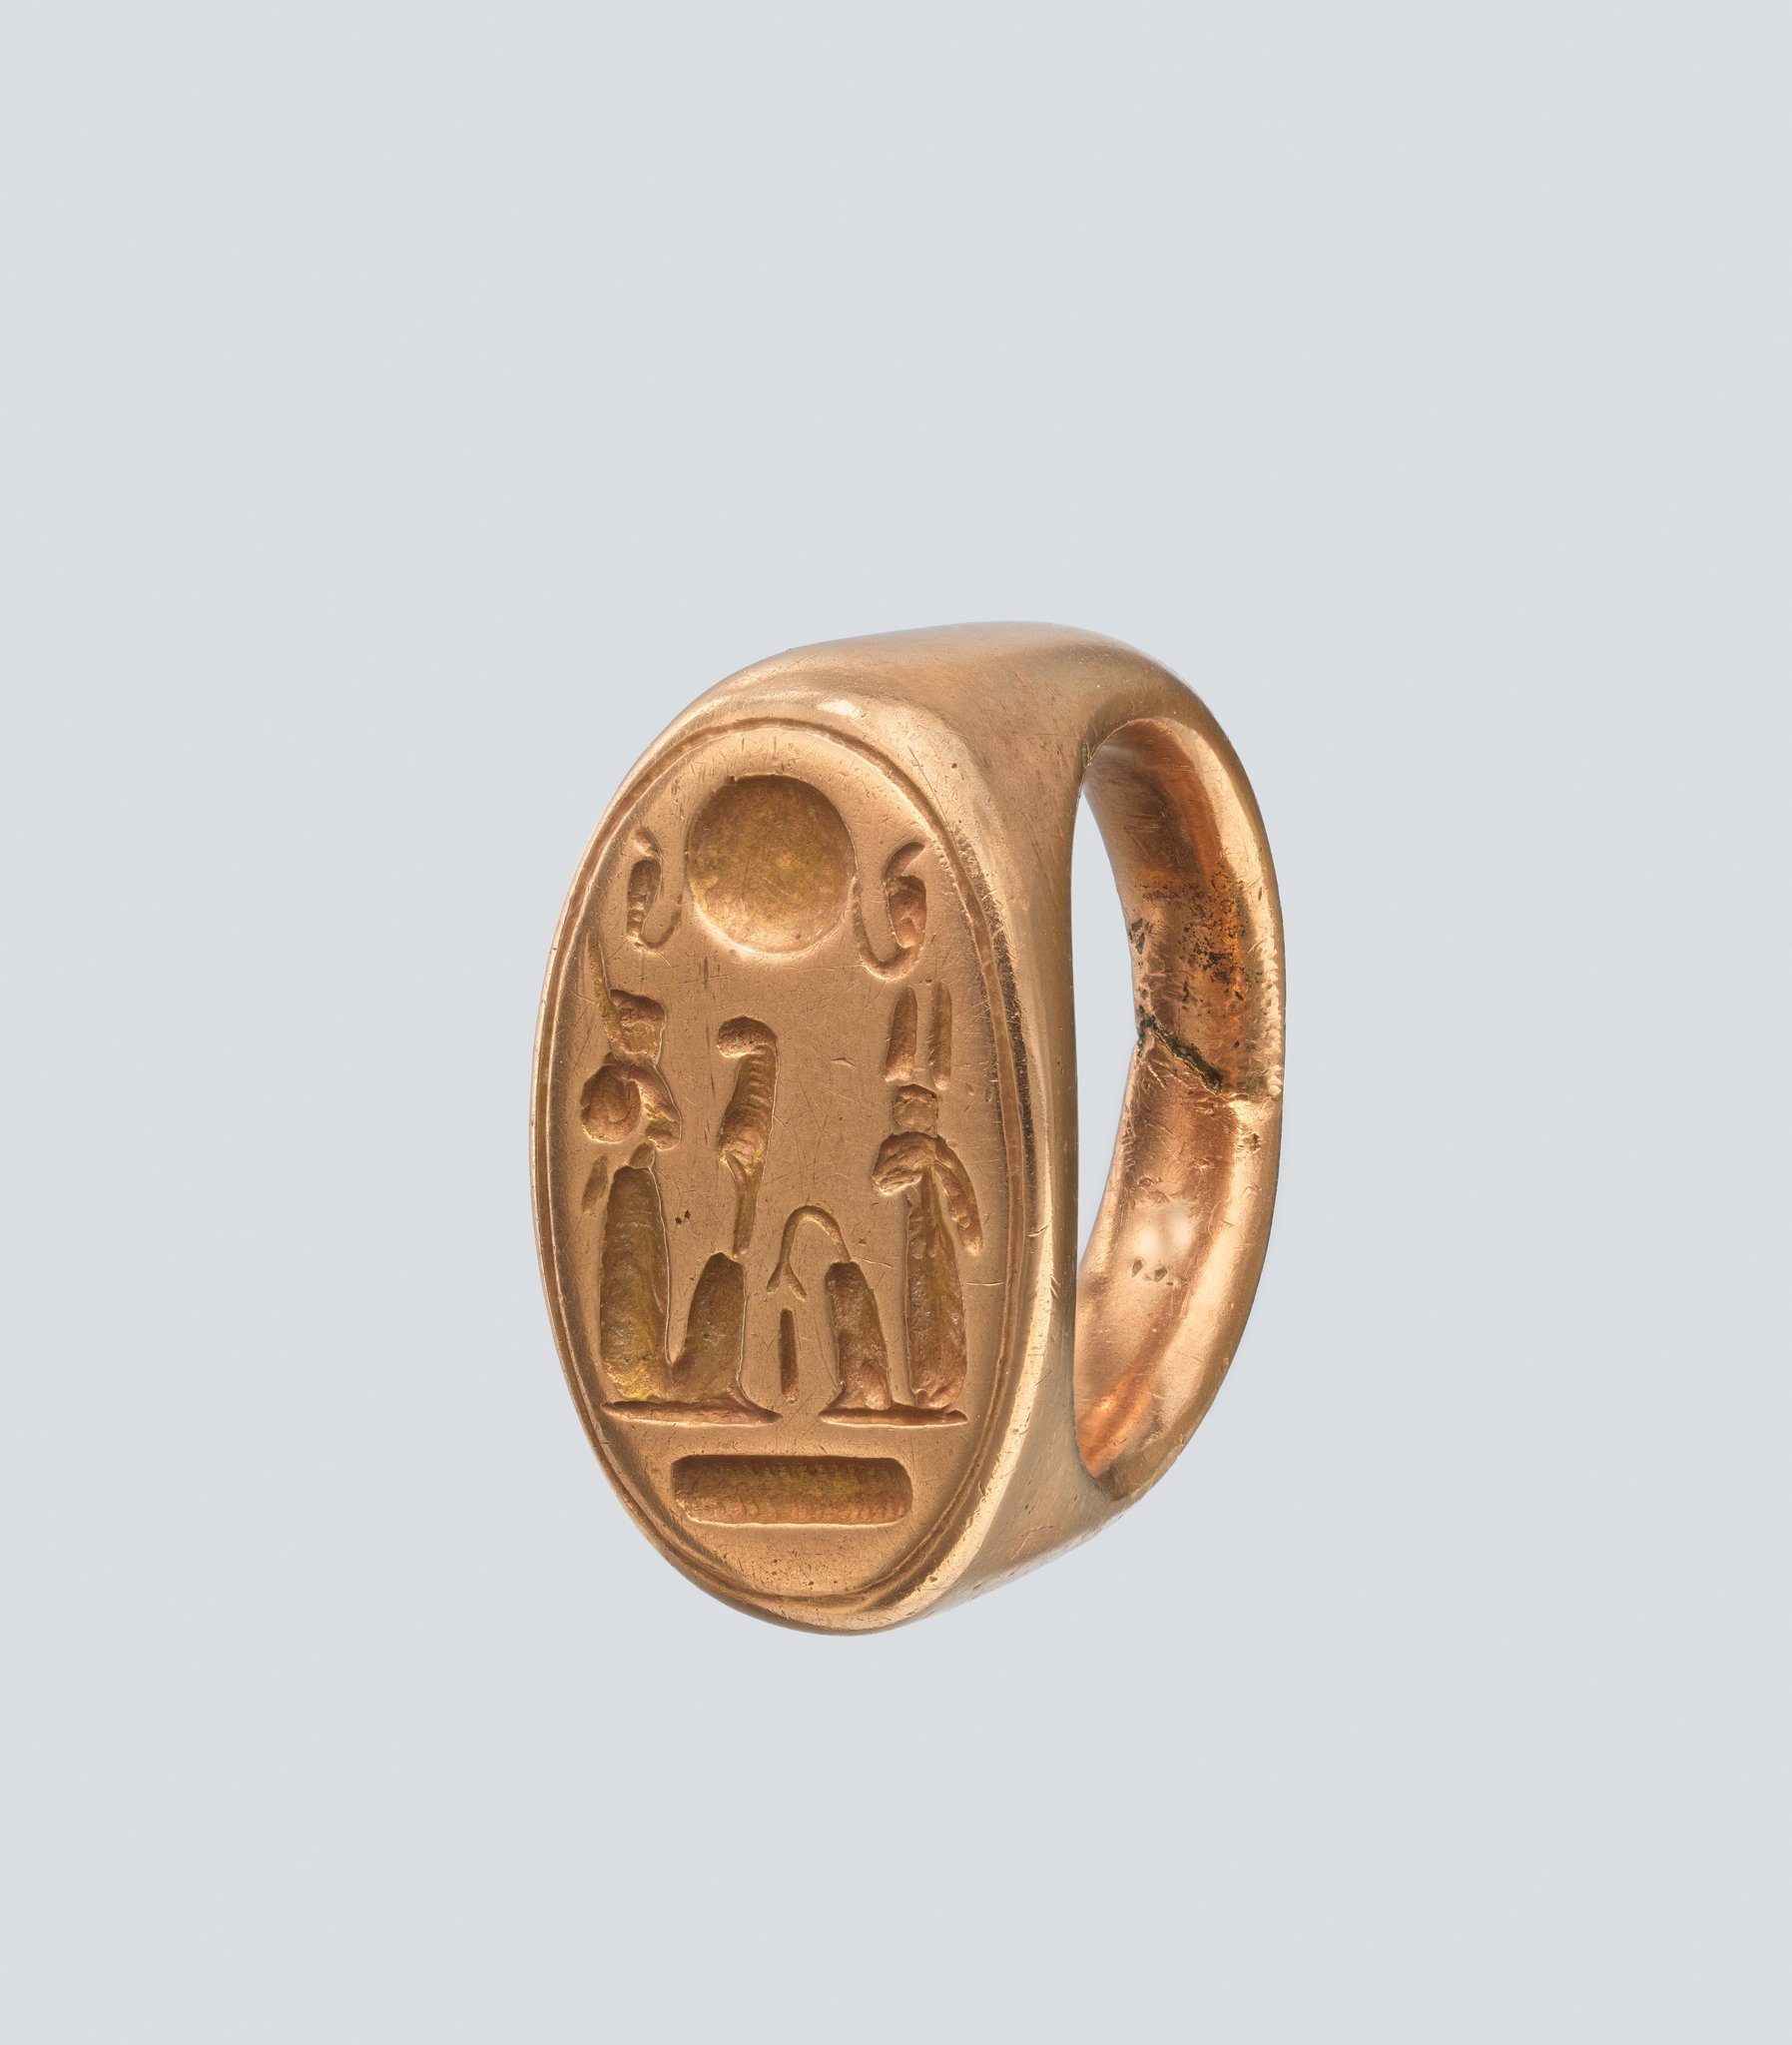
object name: ring with akhenaten and nefertiti a the deity shu and tefnut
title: Finger ring, likely belonging to Queen Tiye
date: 1390-1336 BCE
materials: gold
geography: egypt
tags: kings,nefertiti